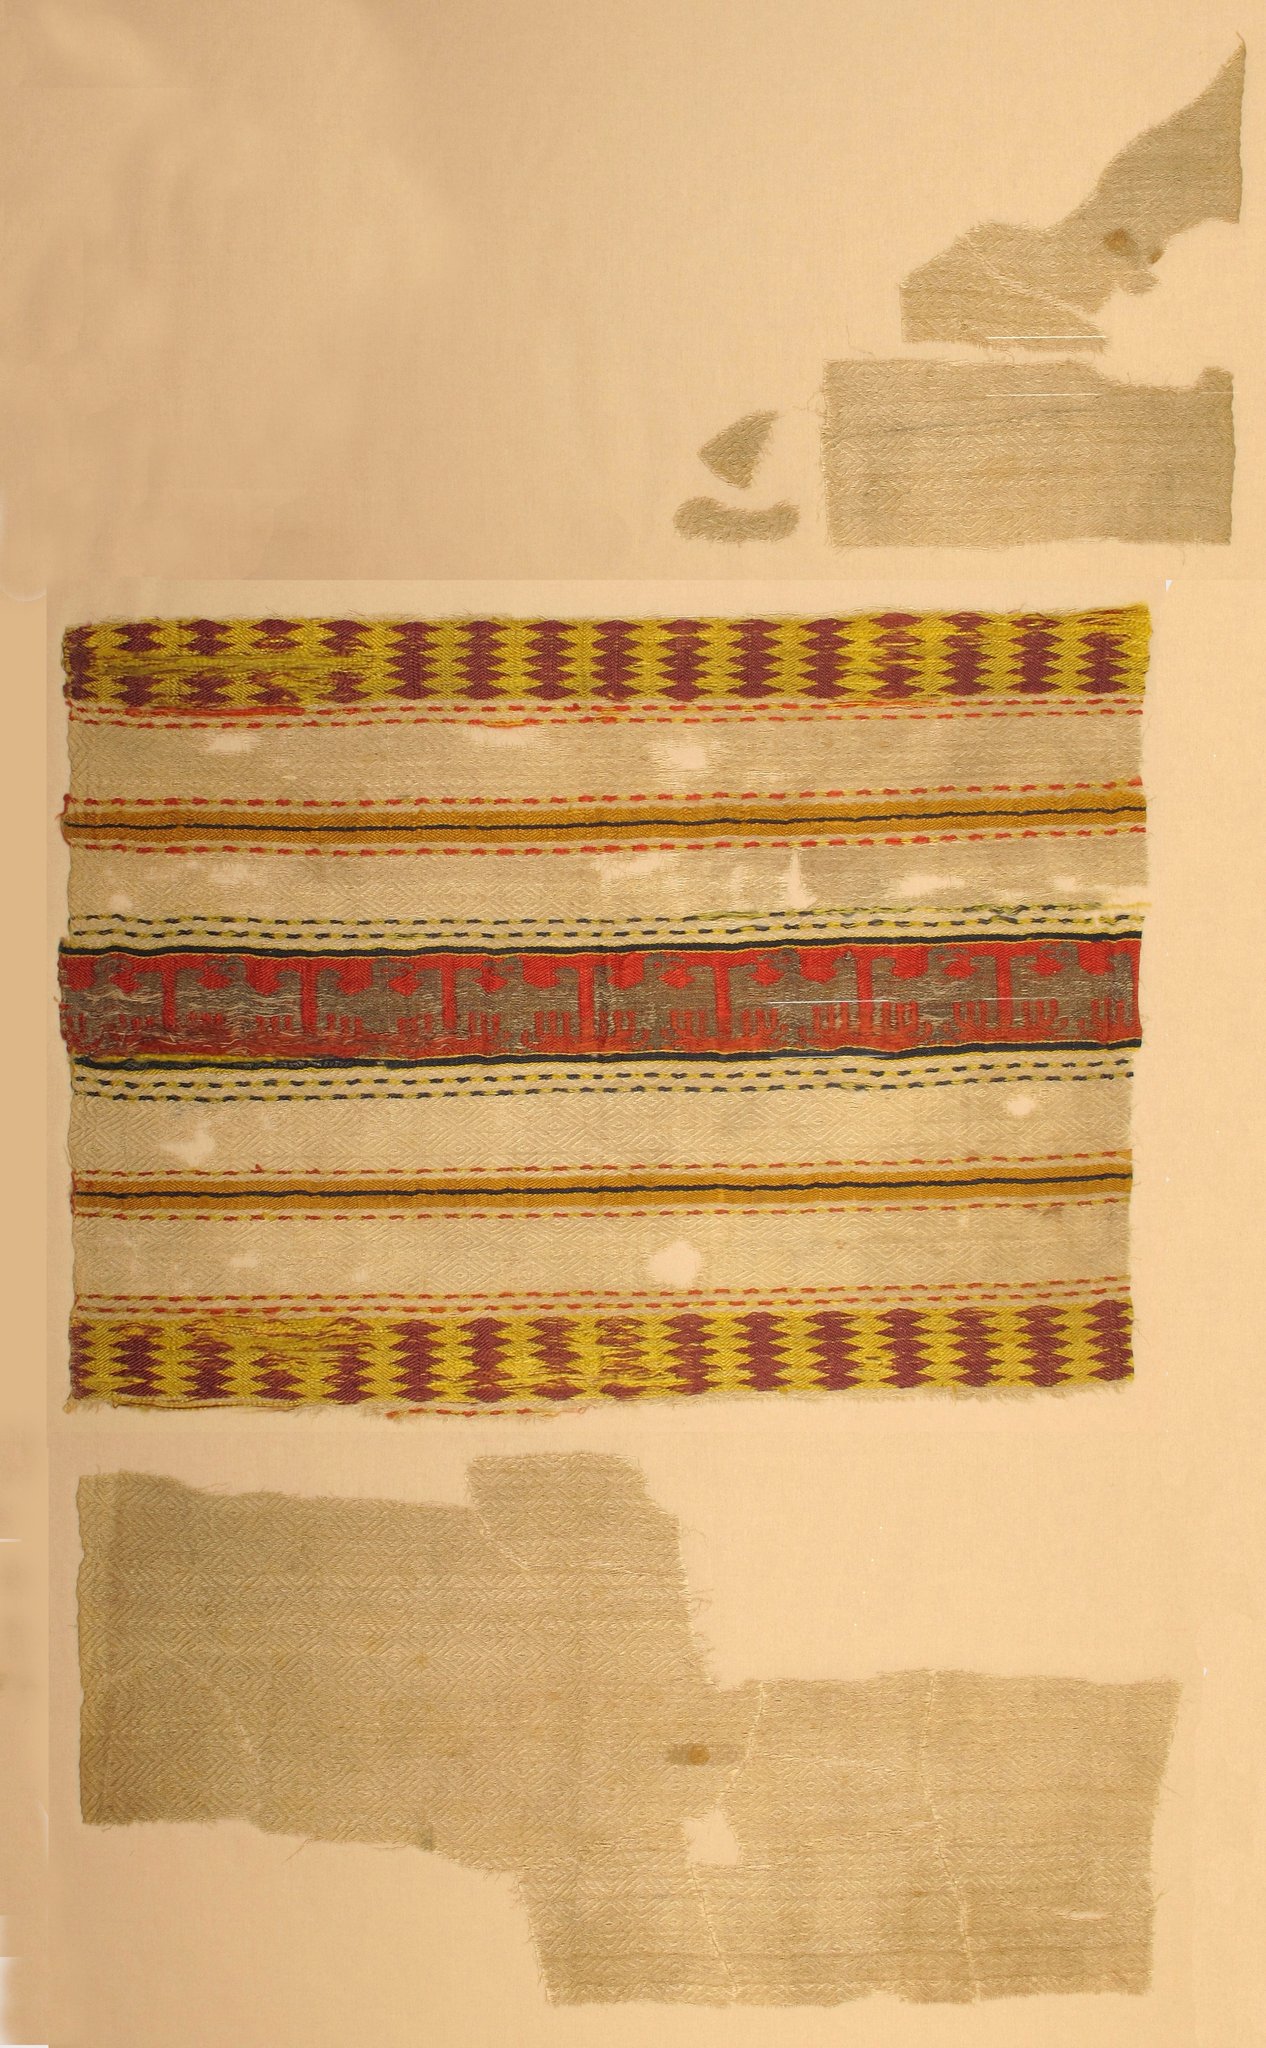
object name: textile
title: Liturgical Towel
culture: italian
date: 1300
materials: linen, metal thread, silk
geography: italy